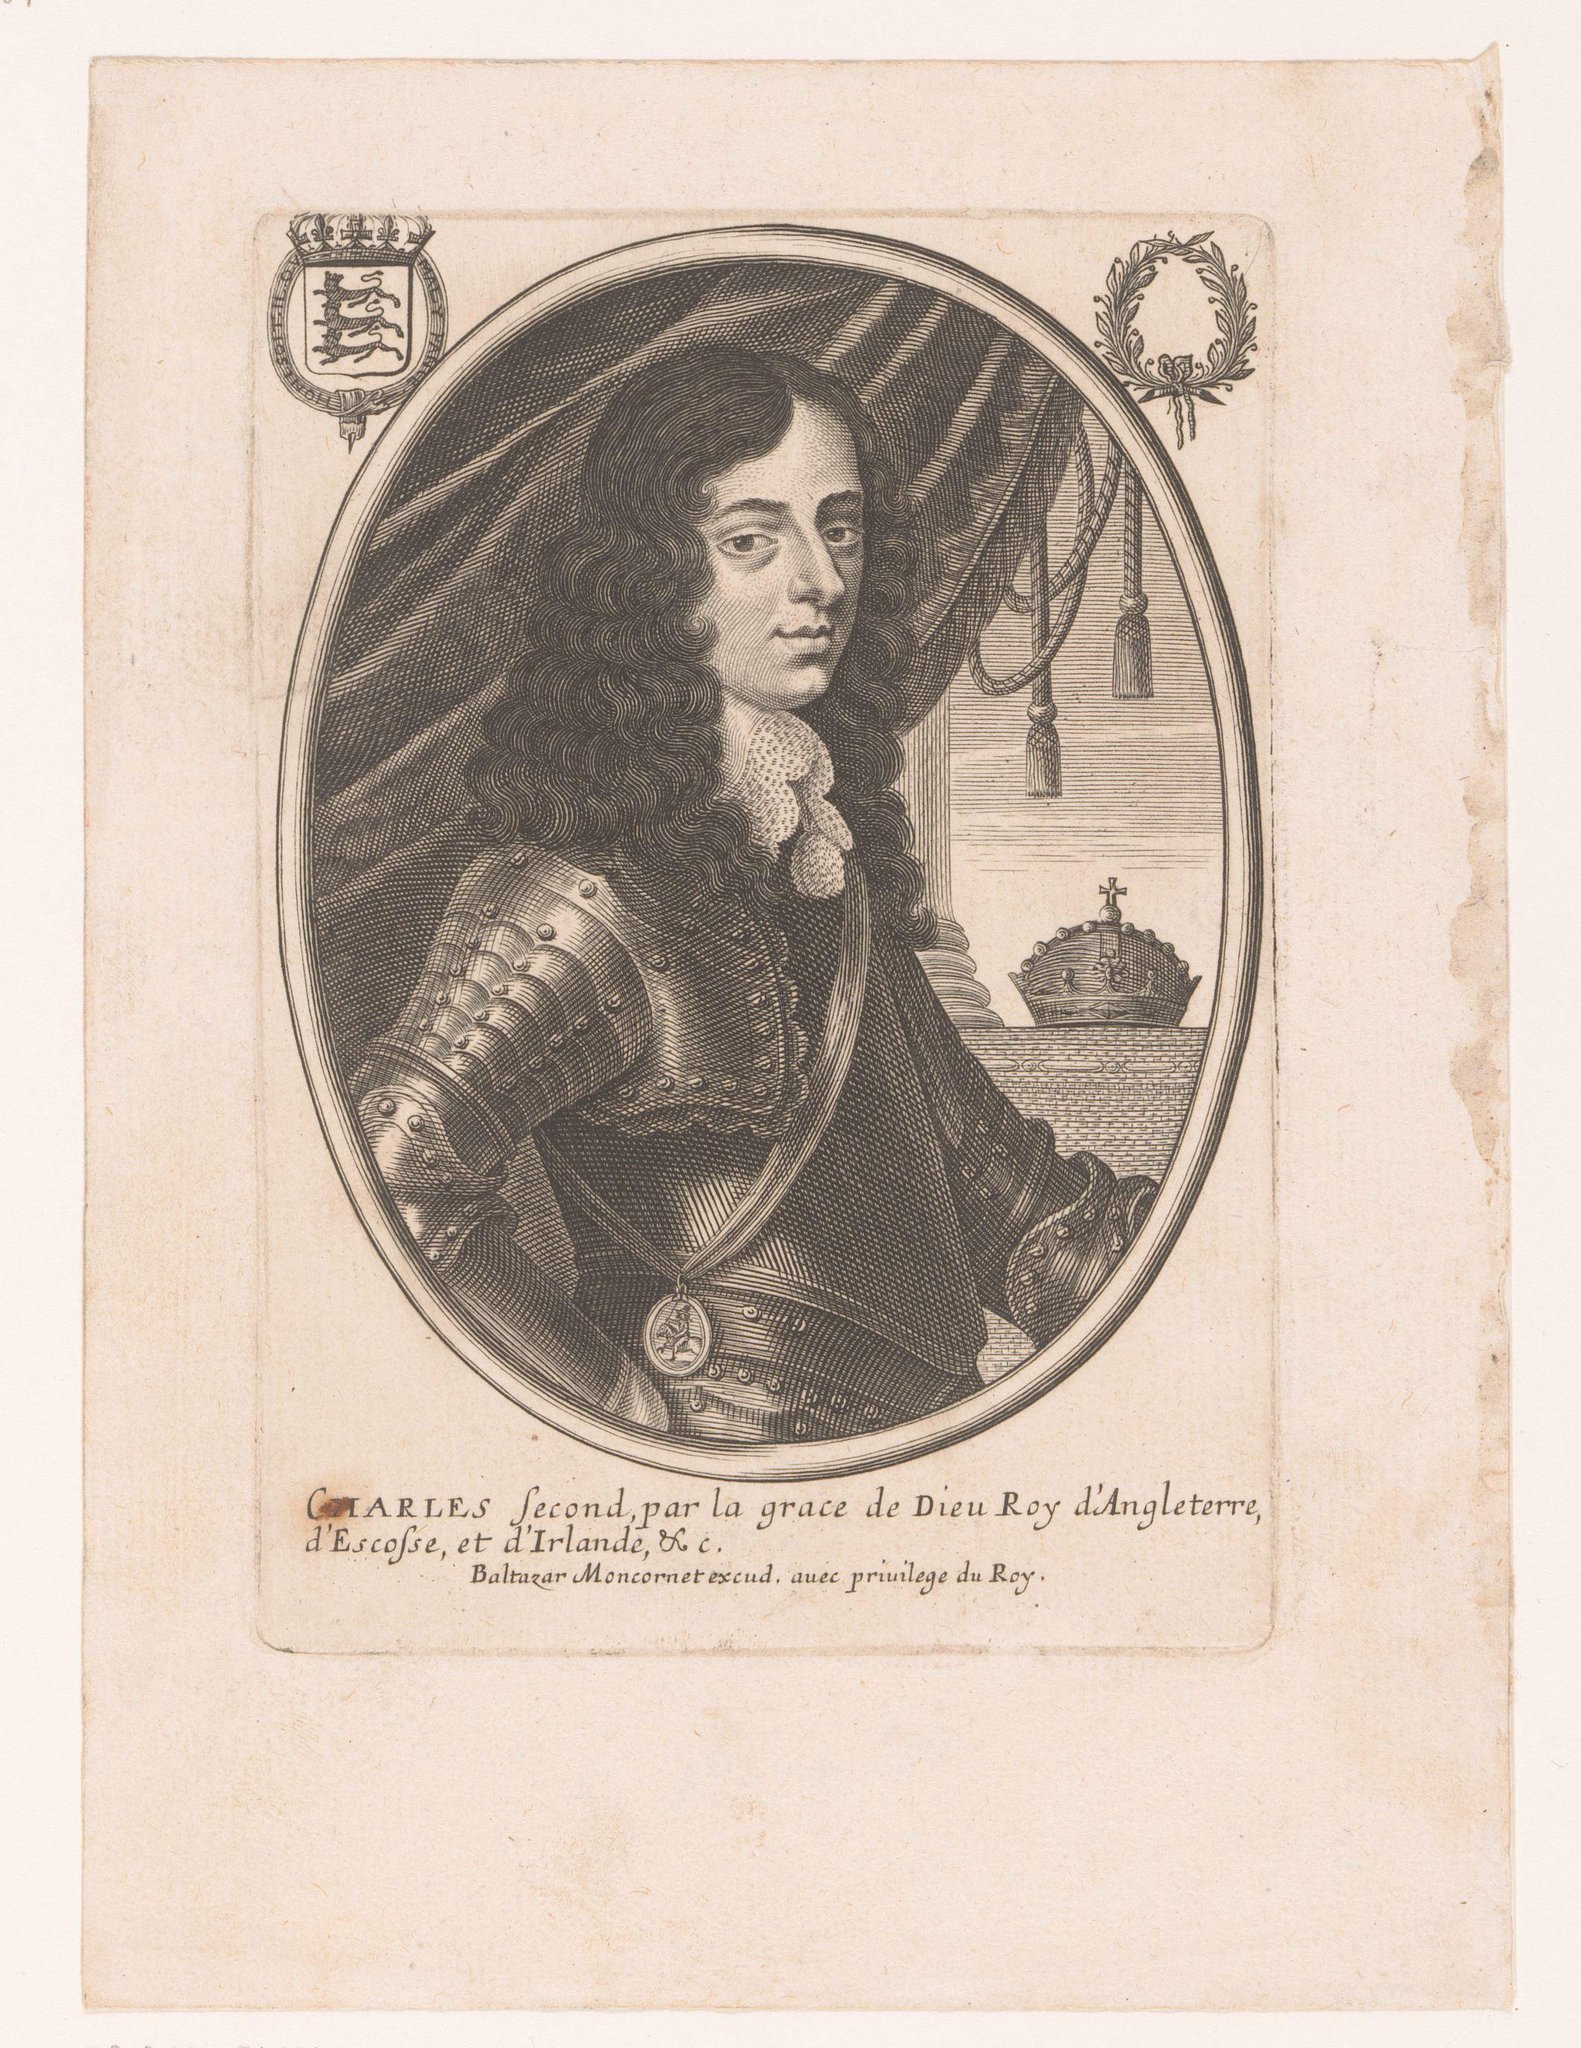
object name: print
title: Portret van Karel II van Engeland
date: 1660-1668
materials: paper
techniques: engraving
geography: france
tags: london, karel ii (koning van engeland), historical persons, king, armorial bearing, heraldry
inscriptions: collector's mark: Lugt 2228